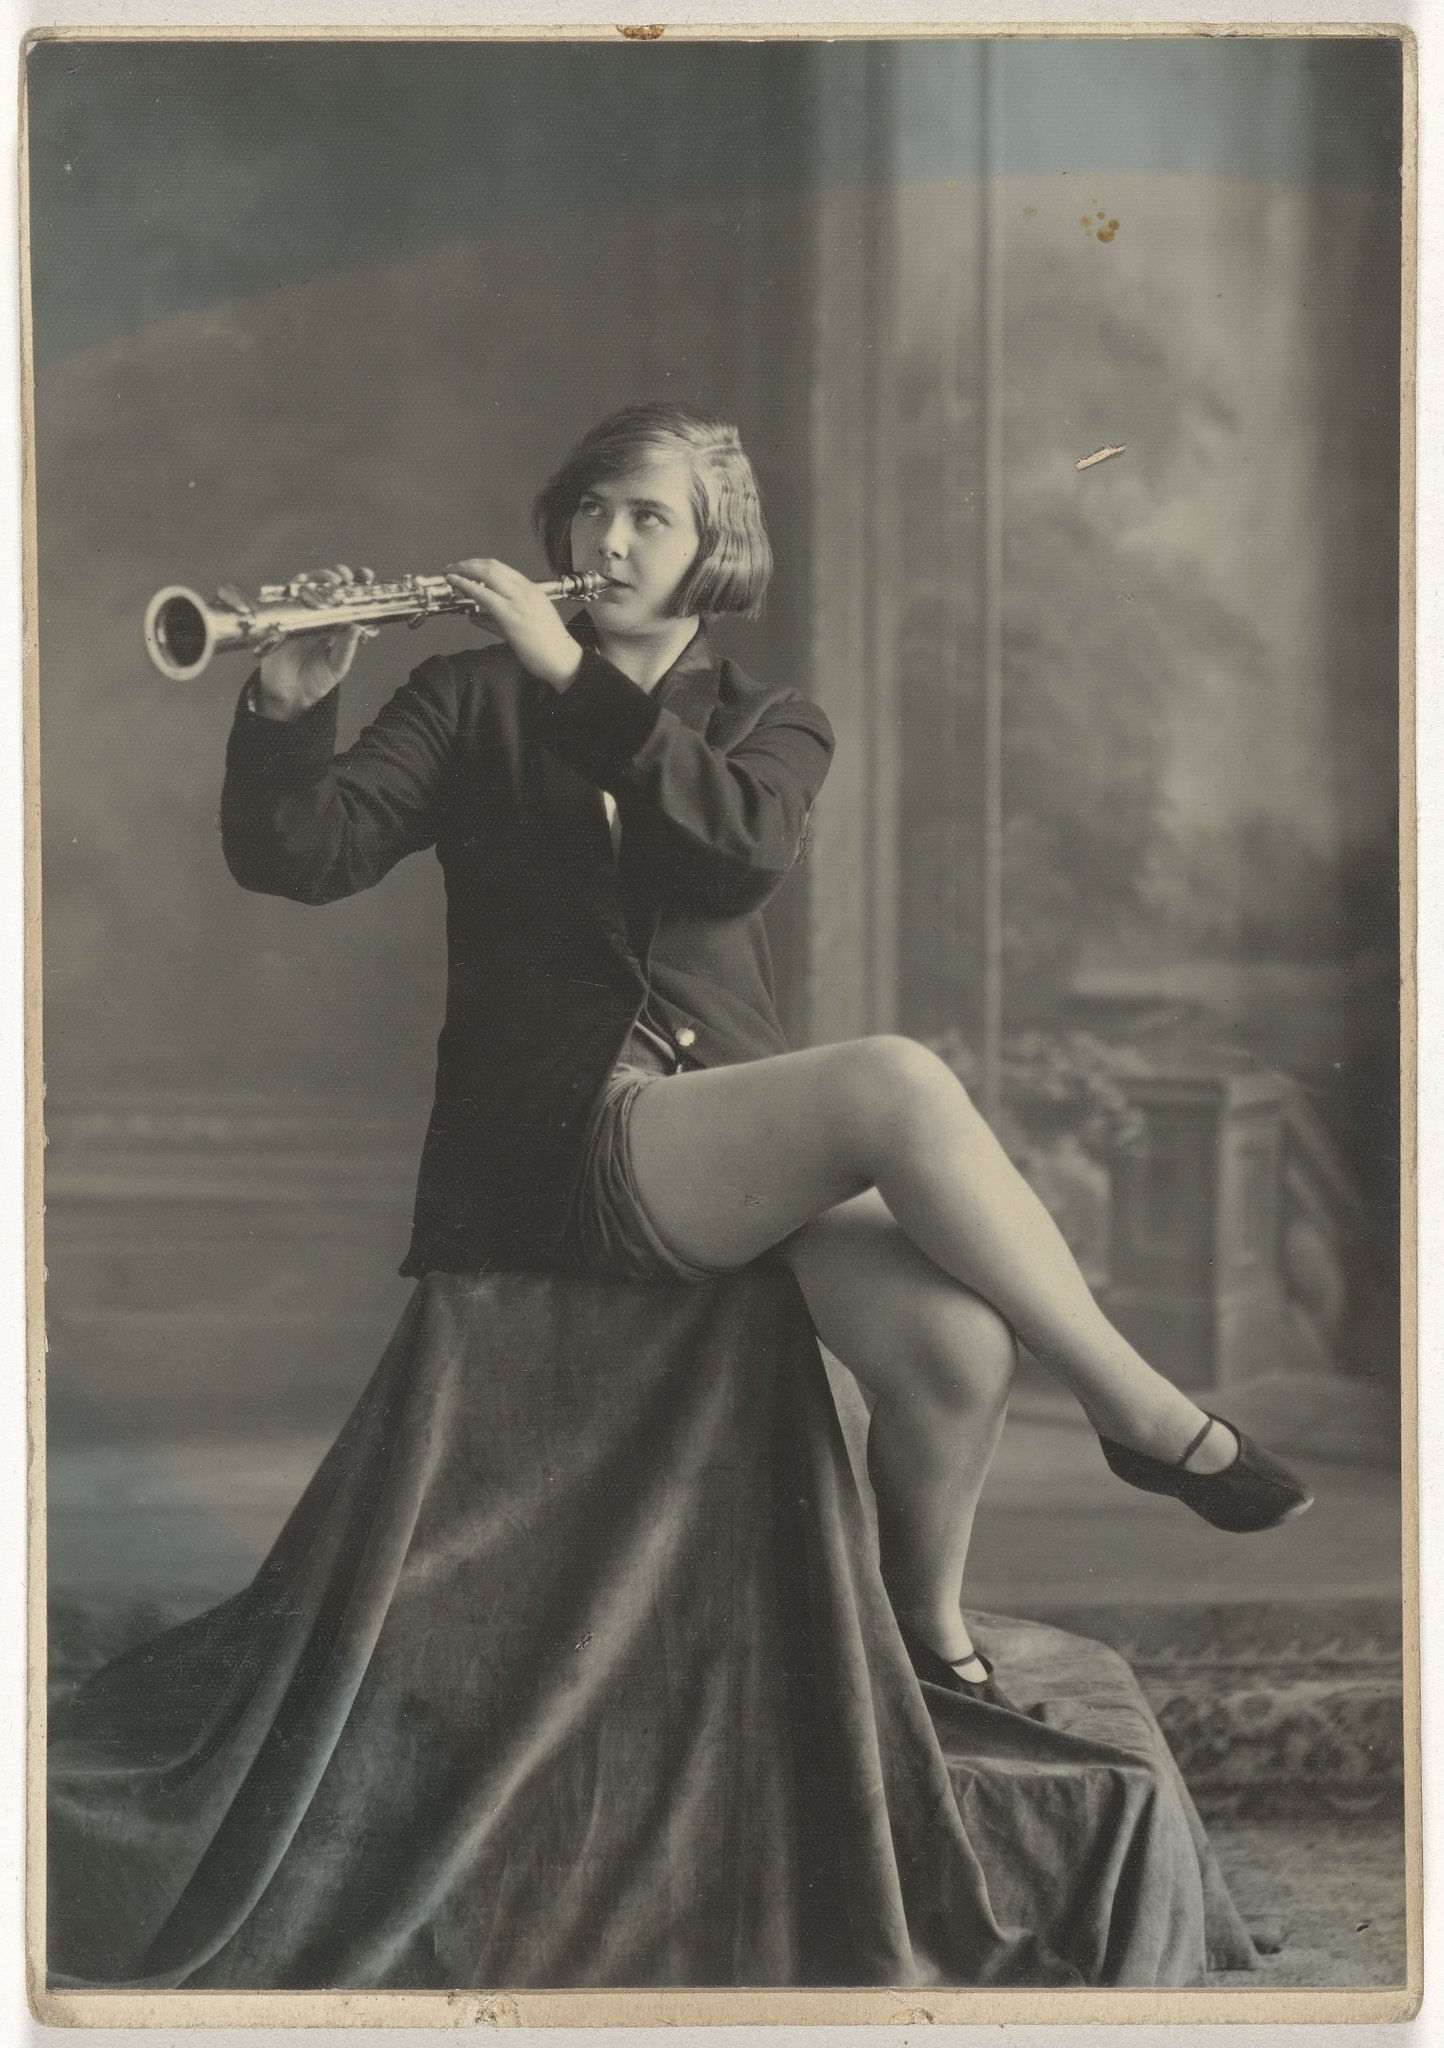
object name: photograph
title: Portret van een onbekend meisje met klarinet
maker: Anonymous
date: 1920-1930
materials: paper, cardboard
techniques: gelatin silver print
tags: clarinet, bassoon, oboe, shawm (+ artist at work)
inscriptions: inscription: ‘3.50’